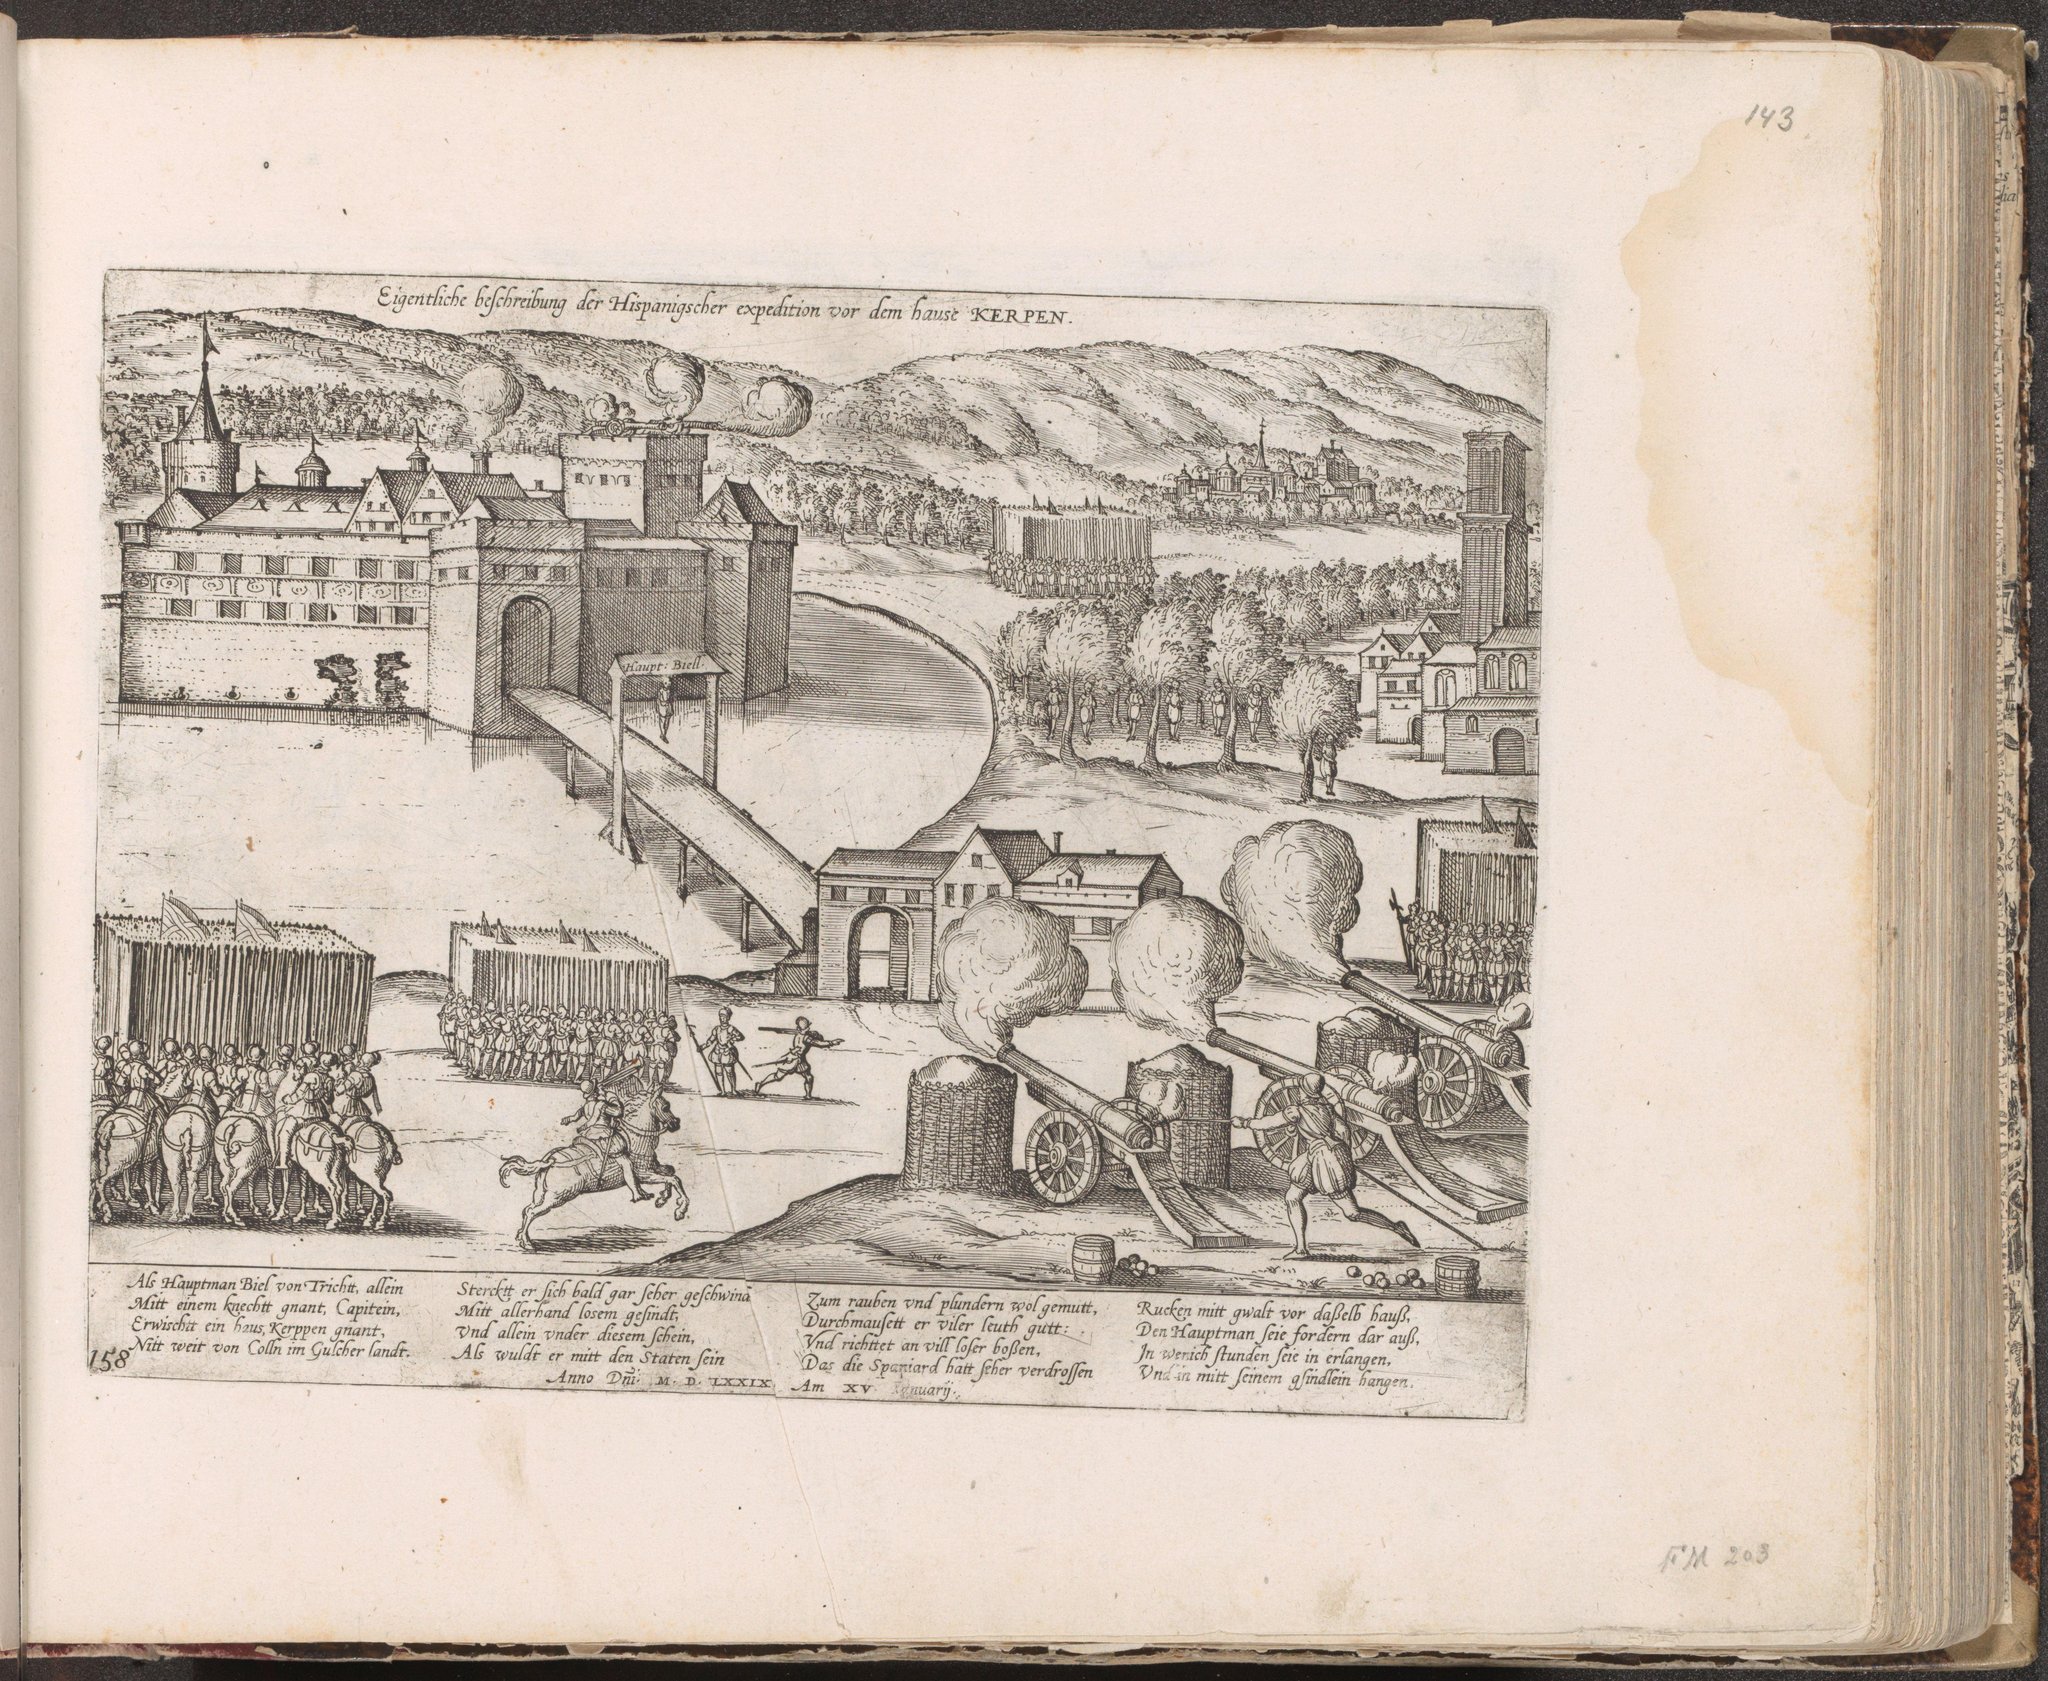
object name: album leaf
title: Eigentliche beschreibung der Hispanigscher expedition vor dem hause Kerpen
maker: frans hogenberg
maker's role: print maker, publisher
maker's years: 1538-1590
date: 1581-1585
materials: paper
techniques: etching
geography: cologne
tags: rome, alessandro farnese (landvoogd van de nederlanden en hertog van parma en piacenza), violent death by hanging, siege, position war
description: Beleg van Kerpen bij Gullik door de troepen van Farnese, 15 januari 1579. Na de verovering van de stad wordt de aanvoerder van de verdedigers Biel samen met anderen opgehangen. Vooraan de beschieting van het slot, op de brug naar het slot hangt het lichaam van Biel. Met onderschrift van 16 regels in het Duits. Linksonder genummerd: 158. De prent maakt deel uit van een album.